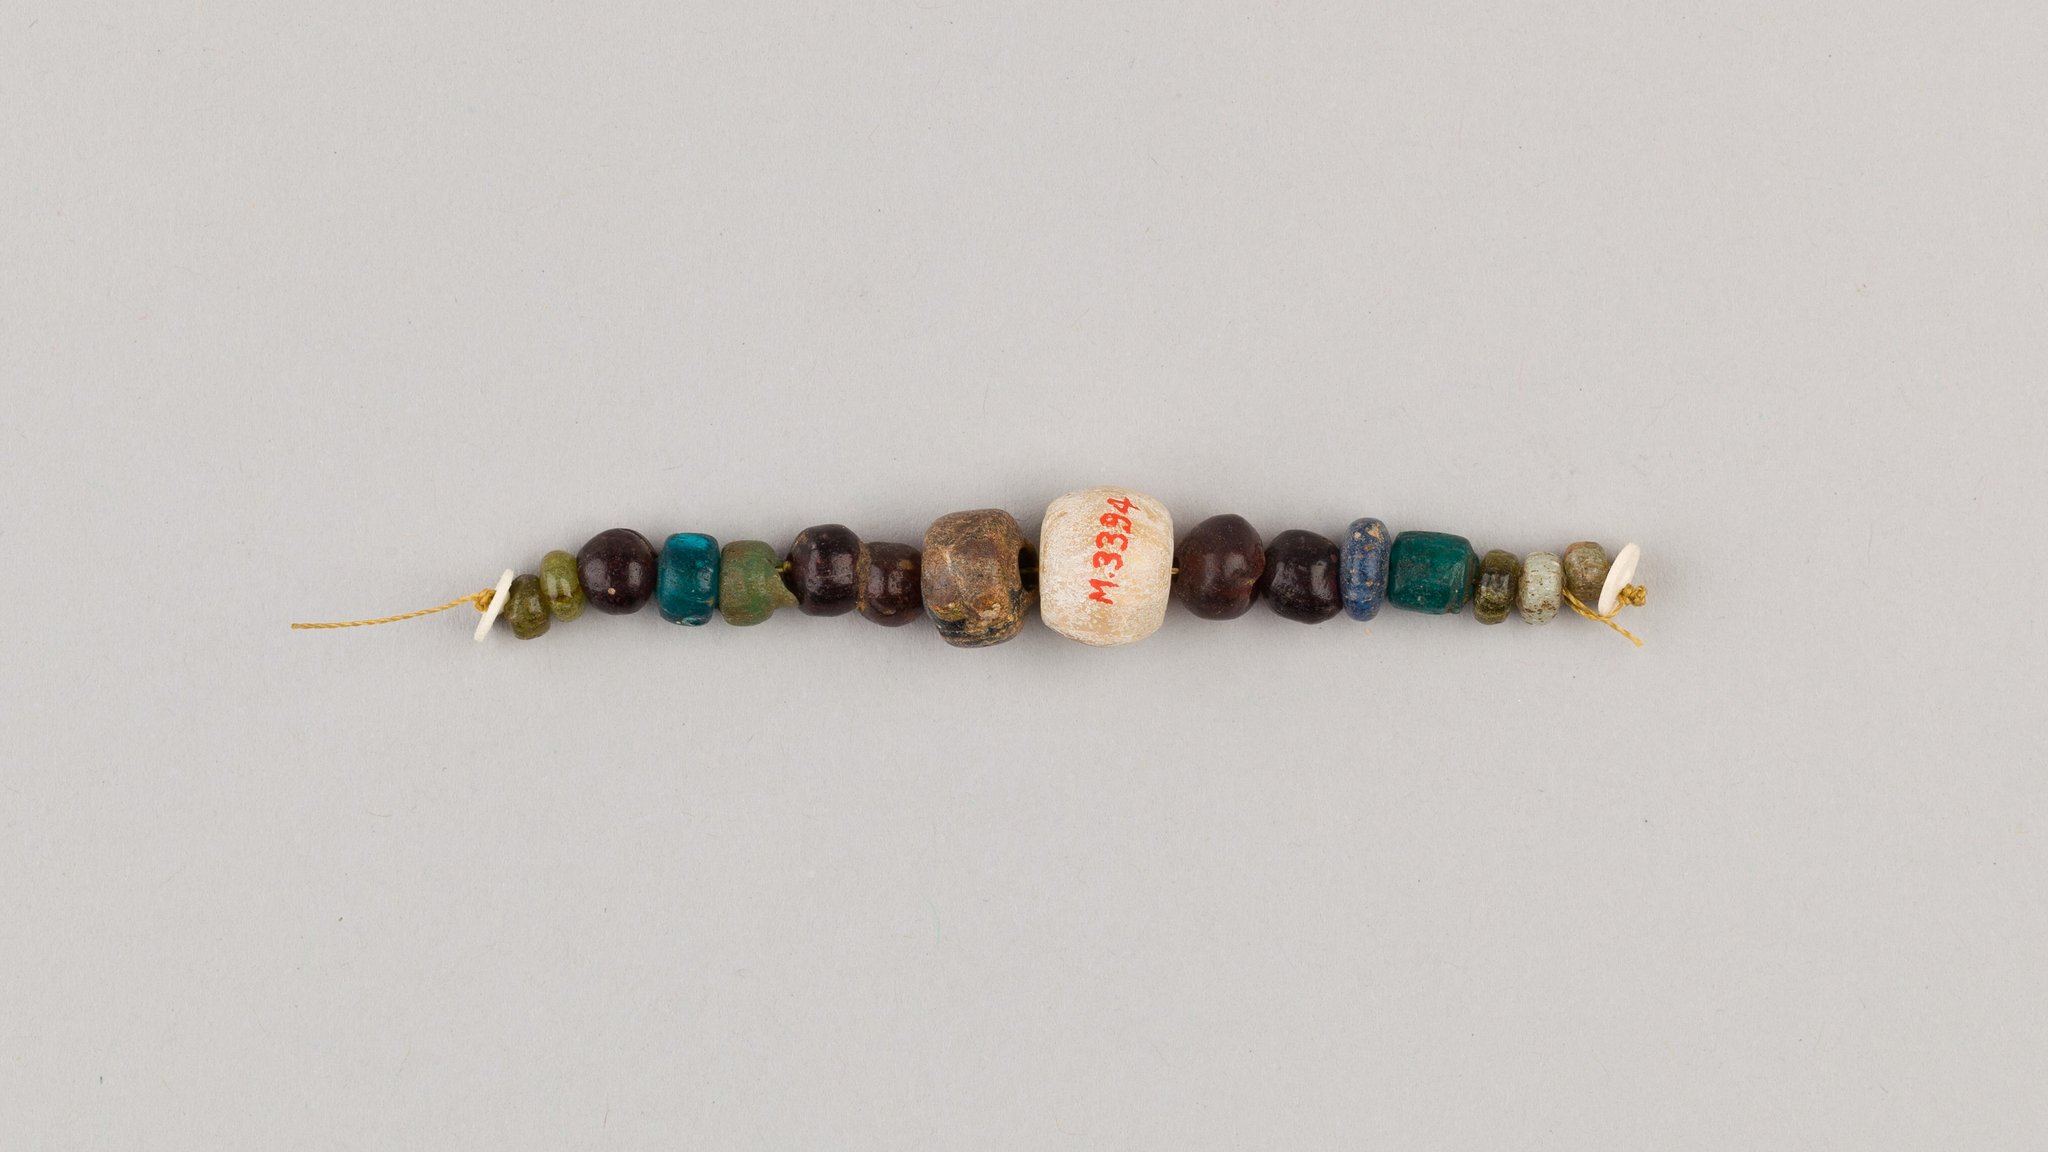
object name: bead, string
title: String of 16 beads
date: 1-100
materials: glass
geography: egypt